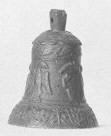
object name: bell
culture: european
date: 1801-1900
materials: metal